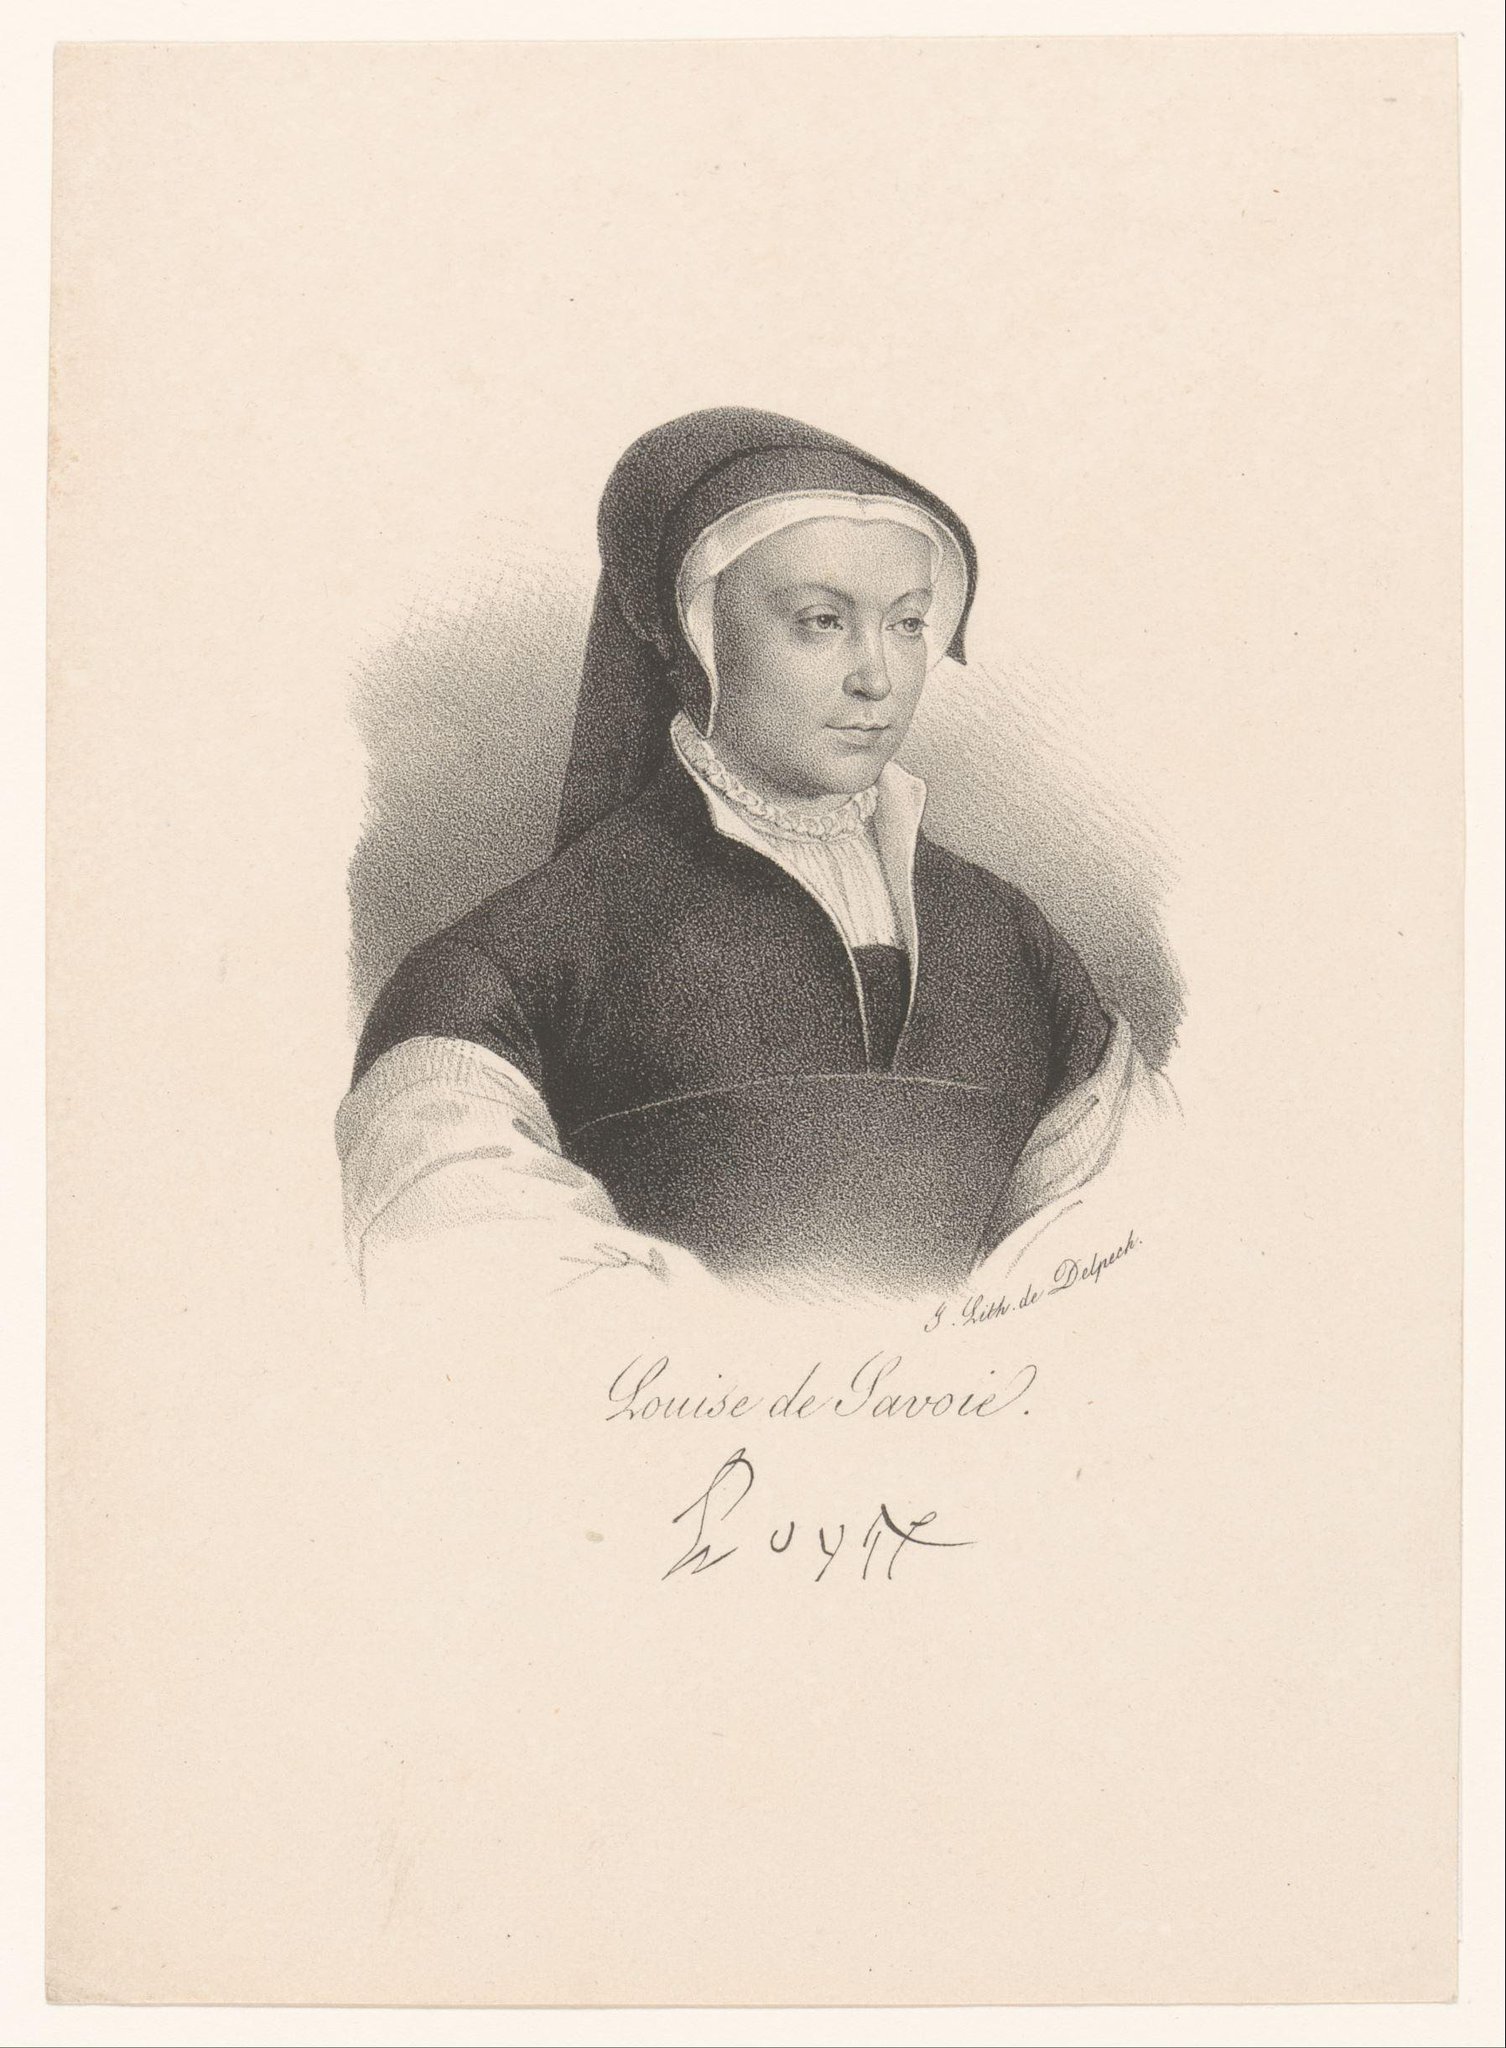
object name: print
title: Portret van Louise van Savoye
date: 1818-1842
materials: paper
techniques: lithograph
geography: paris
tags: historical persons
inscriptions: collector's mark: Lugt 2228a